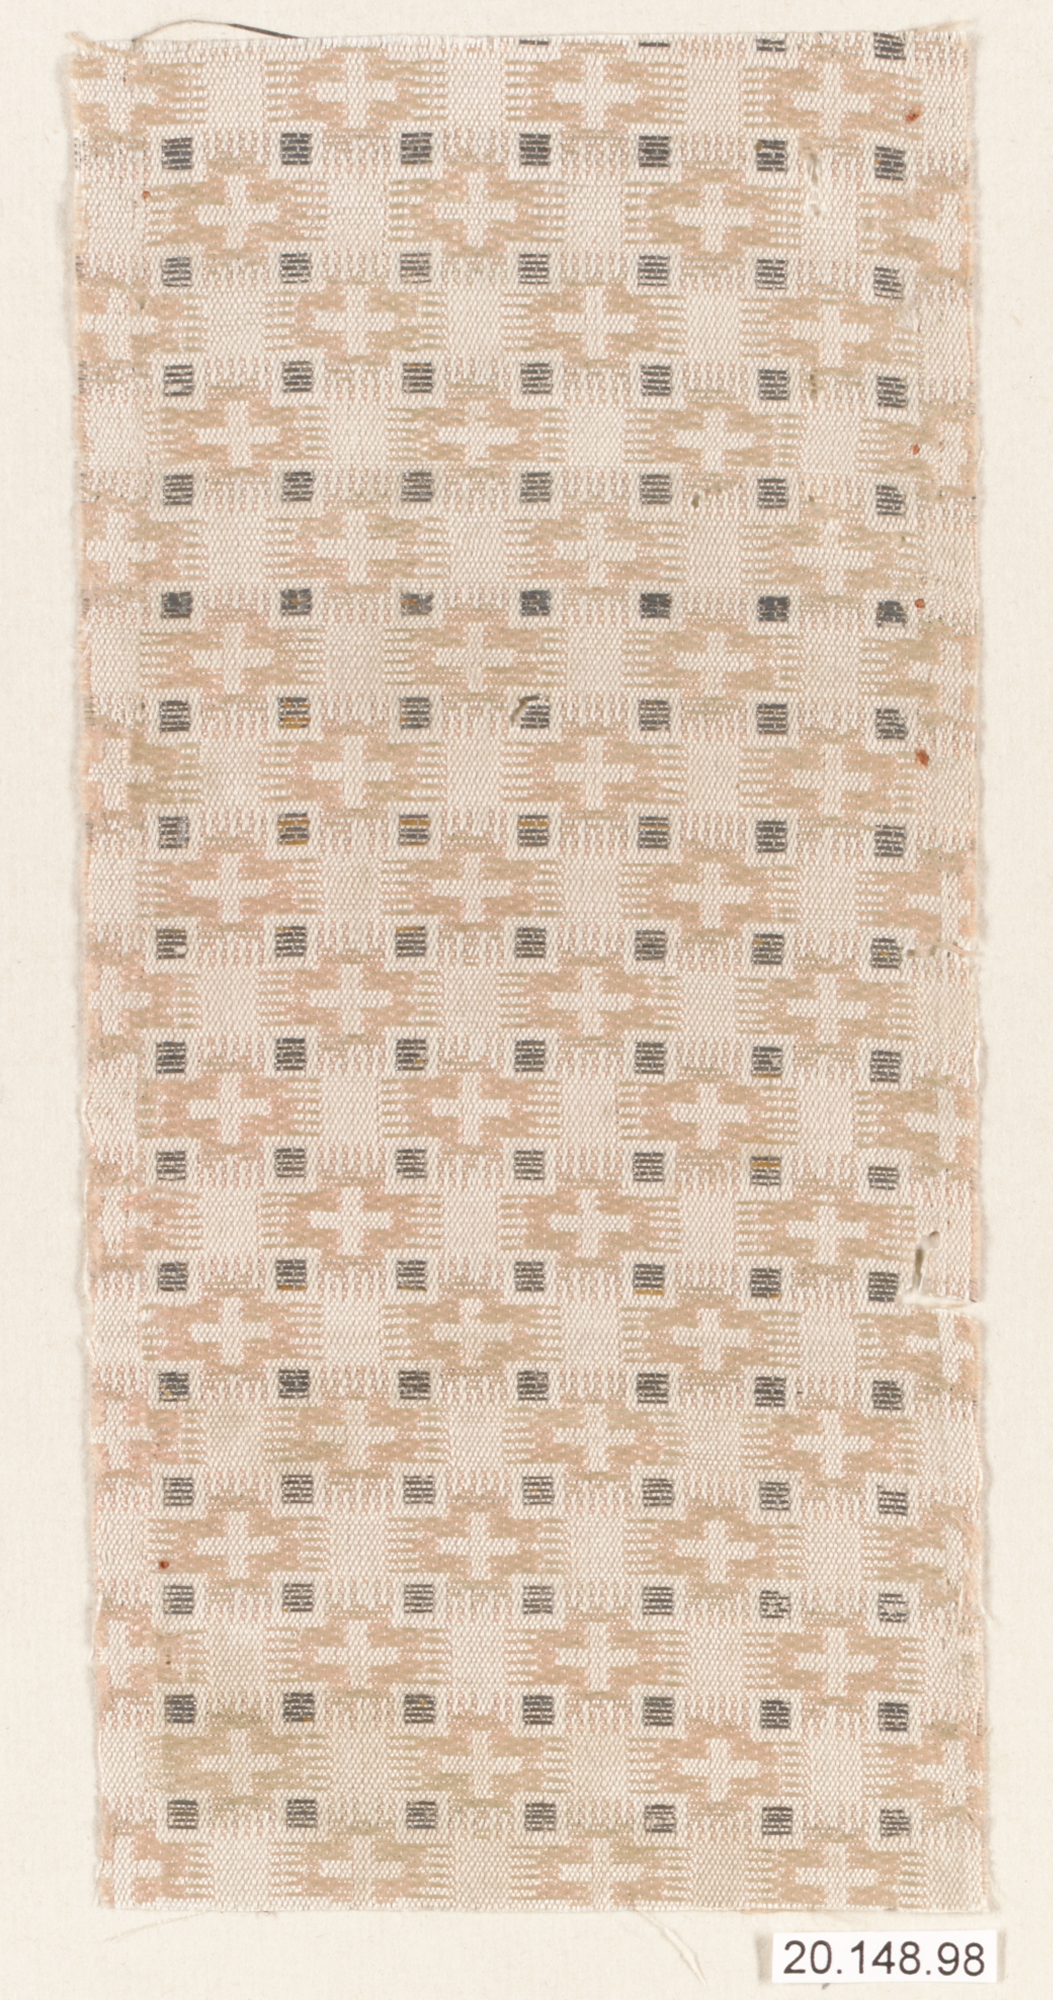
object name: piece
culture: japanese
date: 1701-1800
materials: silk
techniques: compound weave